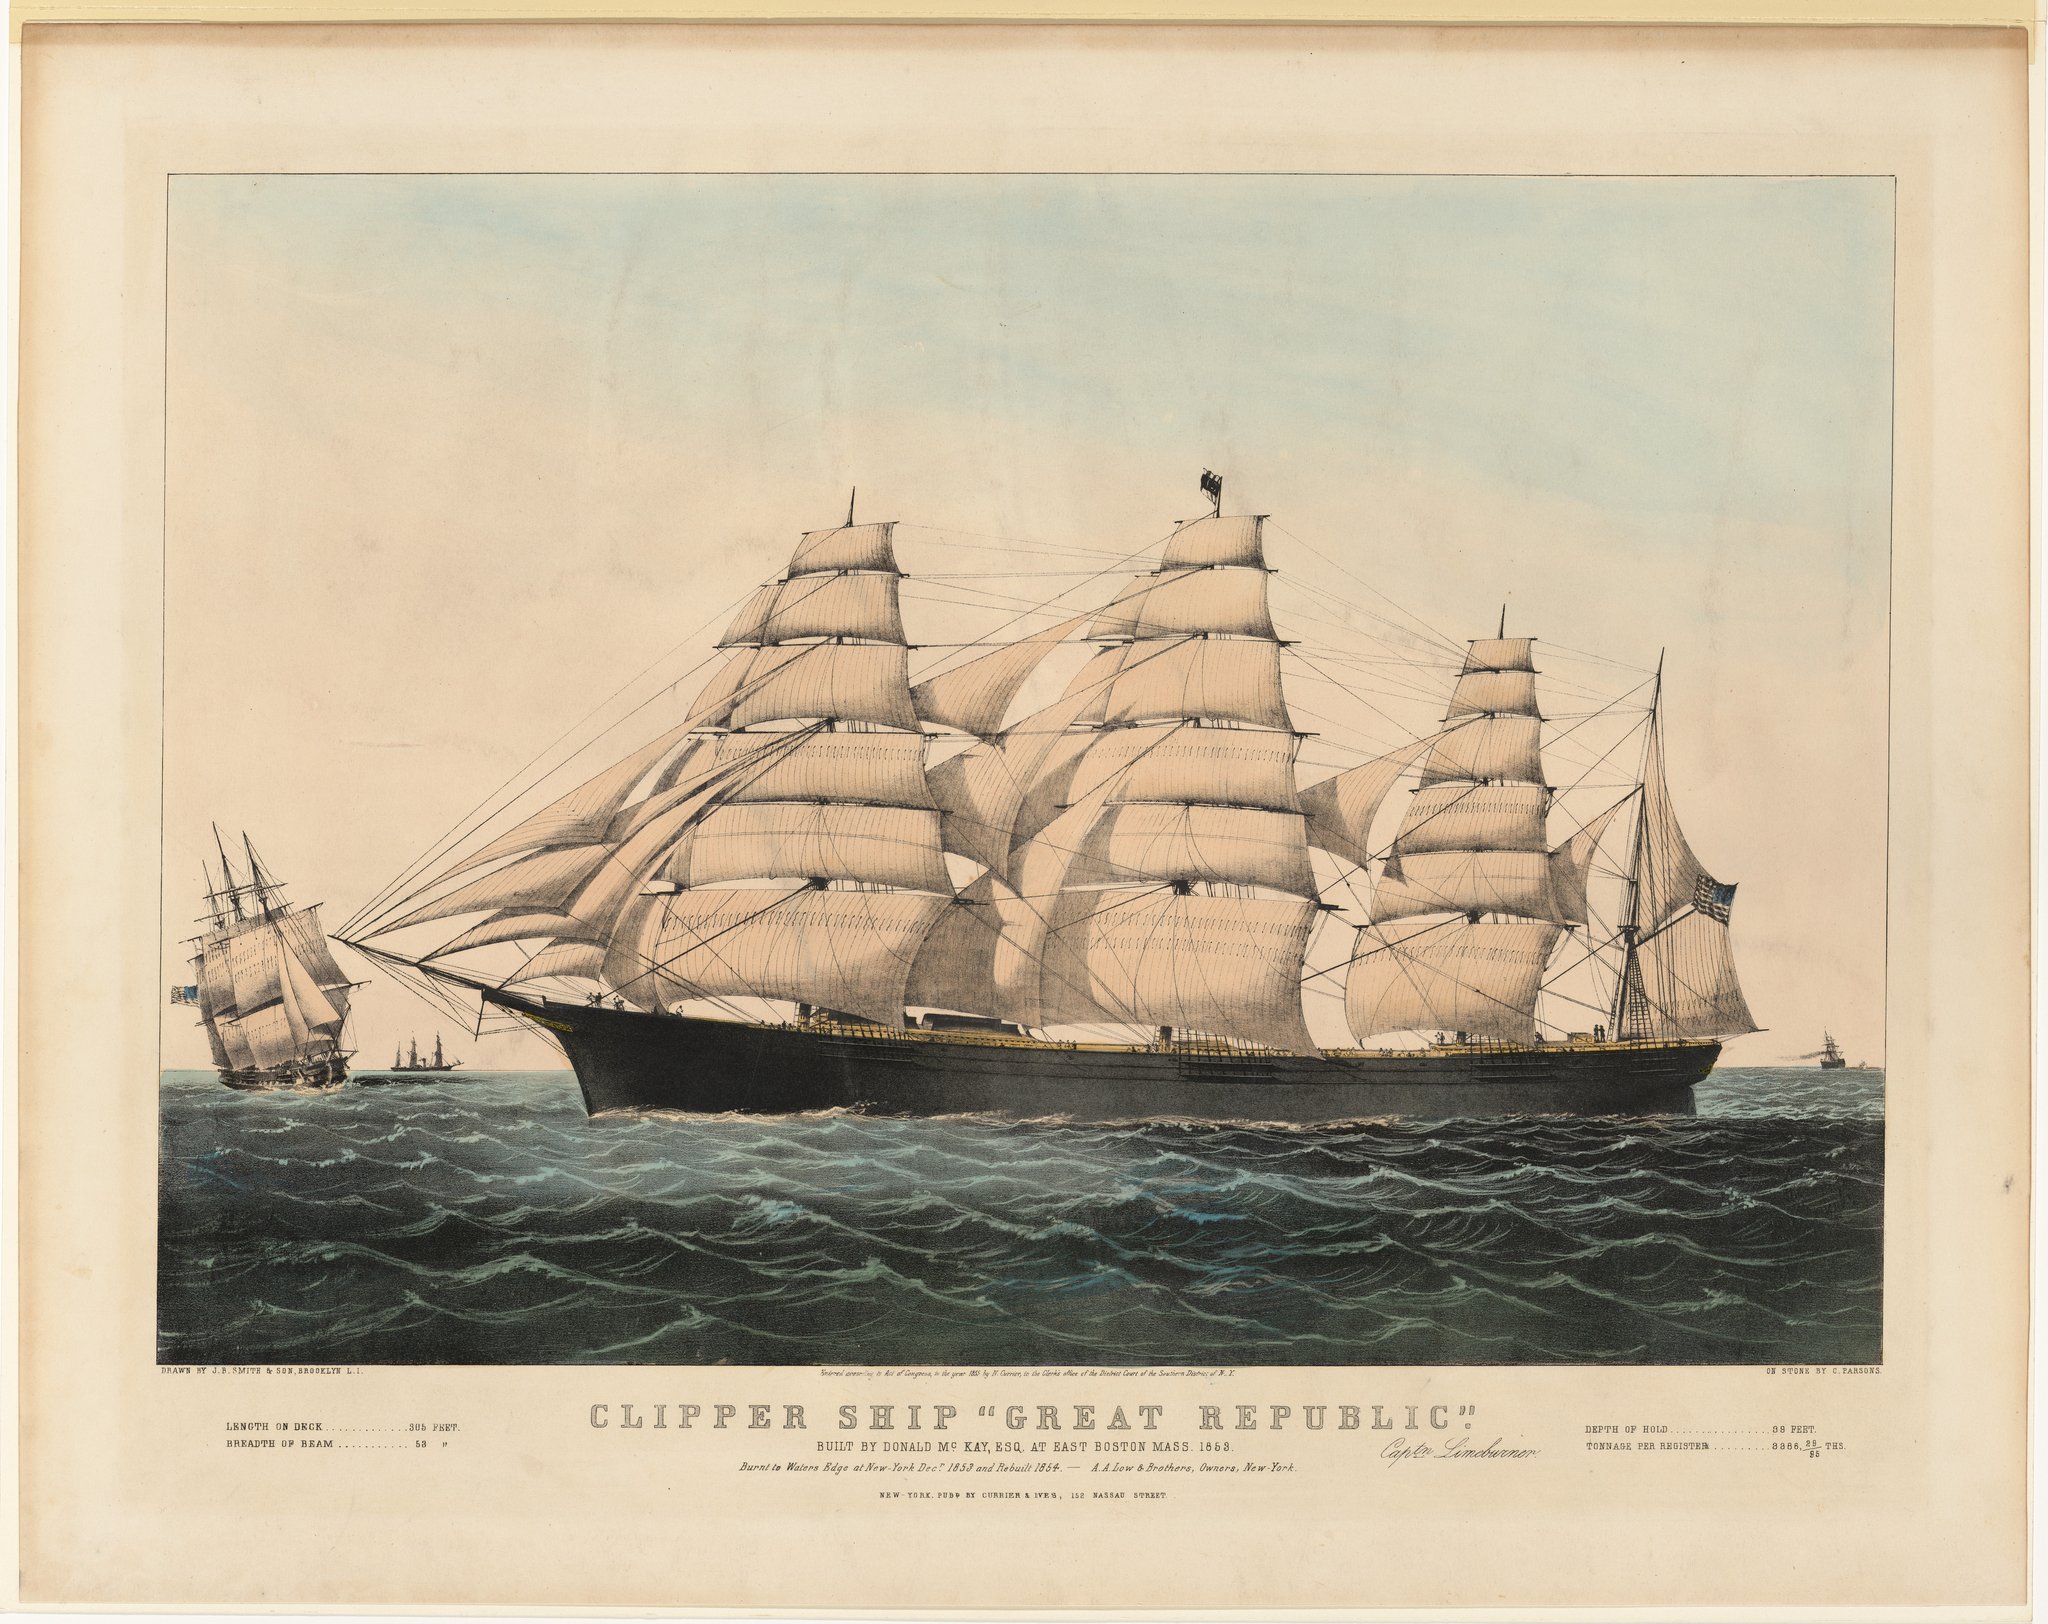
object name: print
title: Clipper Ship "Great Republic"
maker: joseph b. smith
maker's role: artist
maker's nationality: american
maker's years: 1798-1876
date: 1855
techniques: hand coloring, lithograph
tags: ships